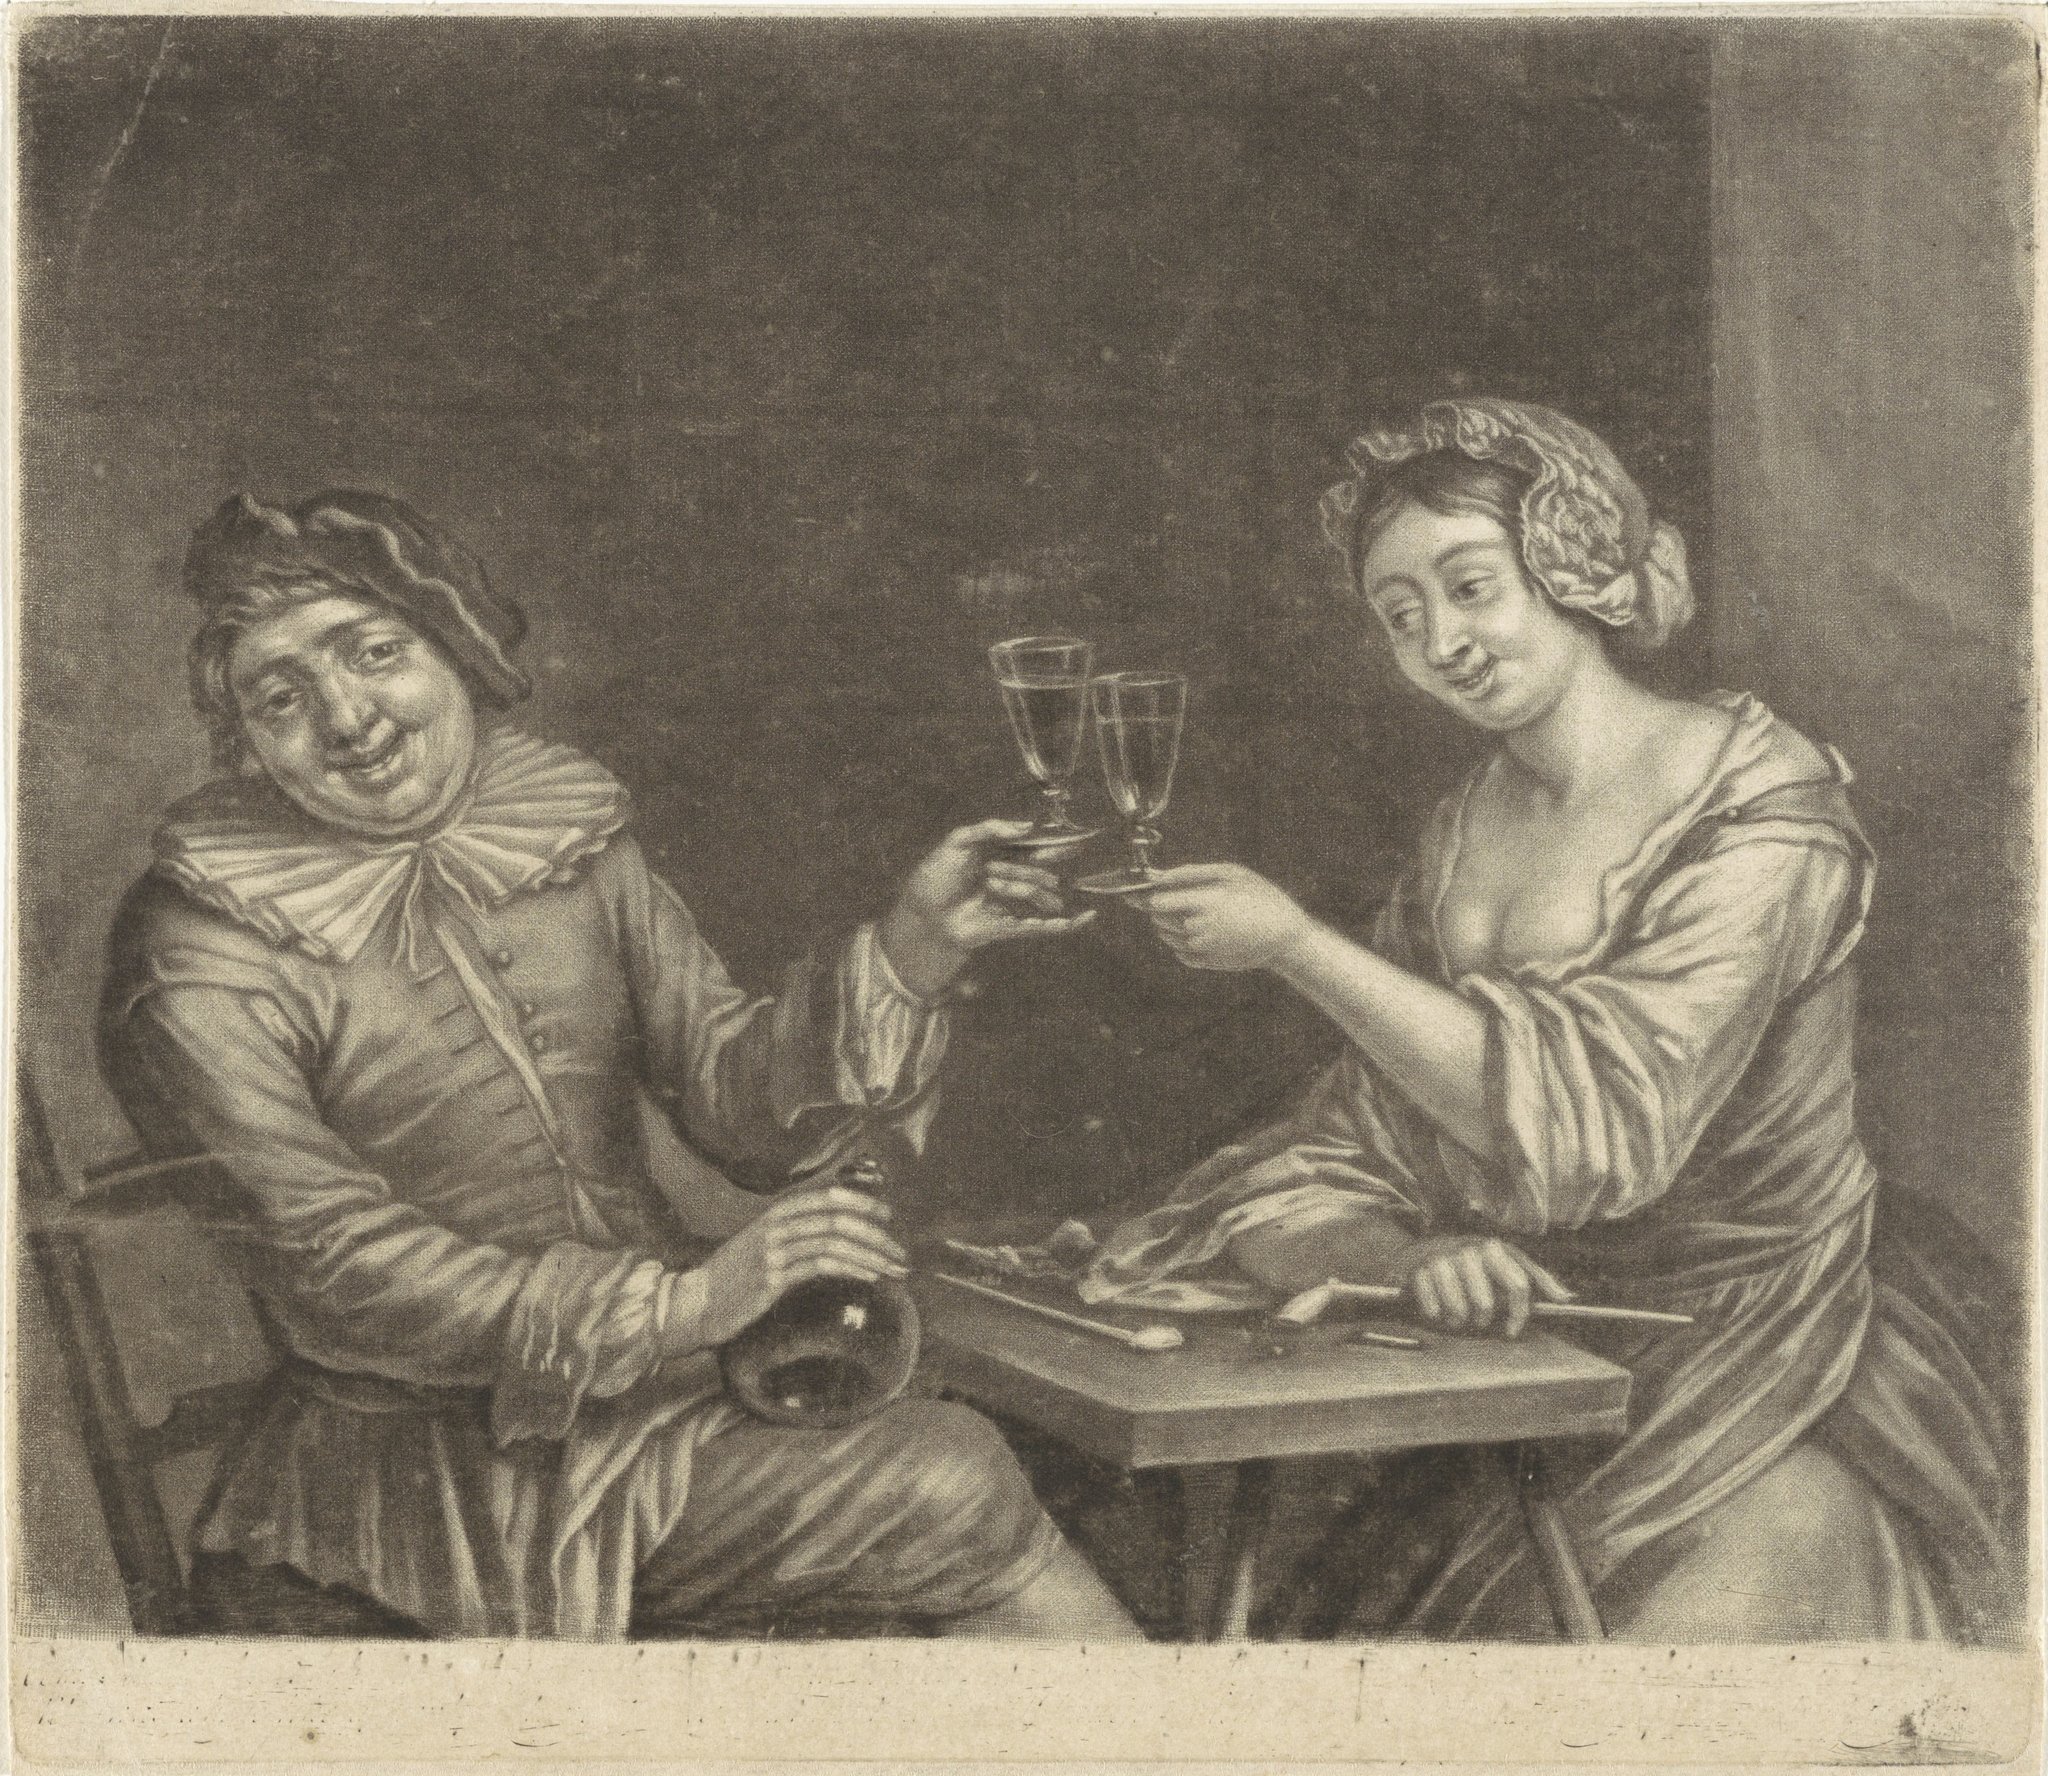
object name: print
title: Proostend paar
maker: marcellus laroon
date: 1663-1702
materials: paper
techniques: mezzotint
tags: glass of wine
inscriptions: collector's mark: Lugt 2760, collector's mark: Lugt 2228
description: Een man en een vrouw klinken hun glazen tegen elkaar. Op de tafel, waaraan ze zitten, liggen pijpjes.